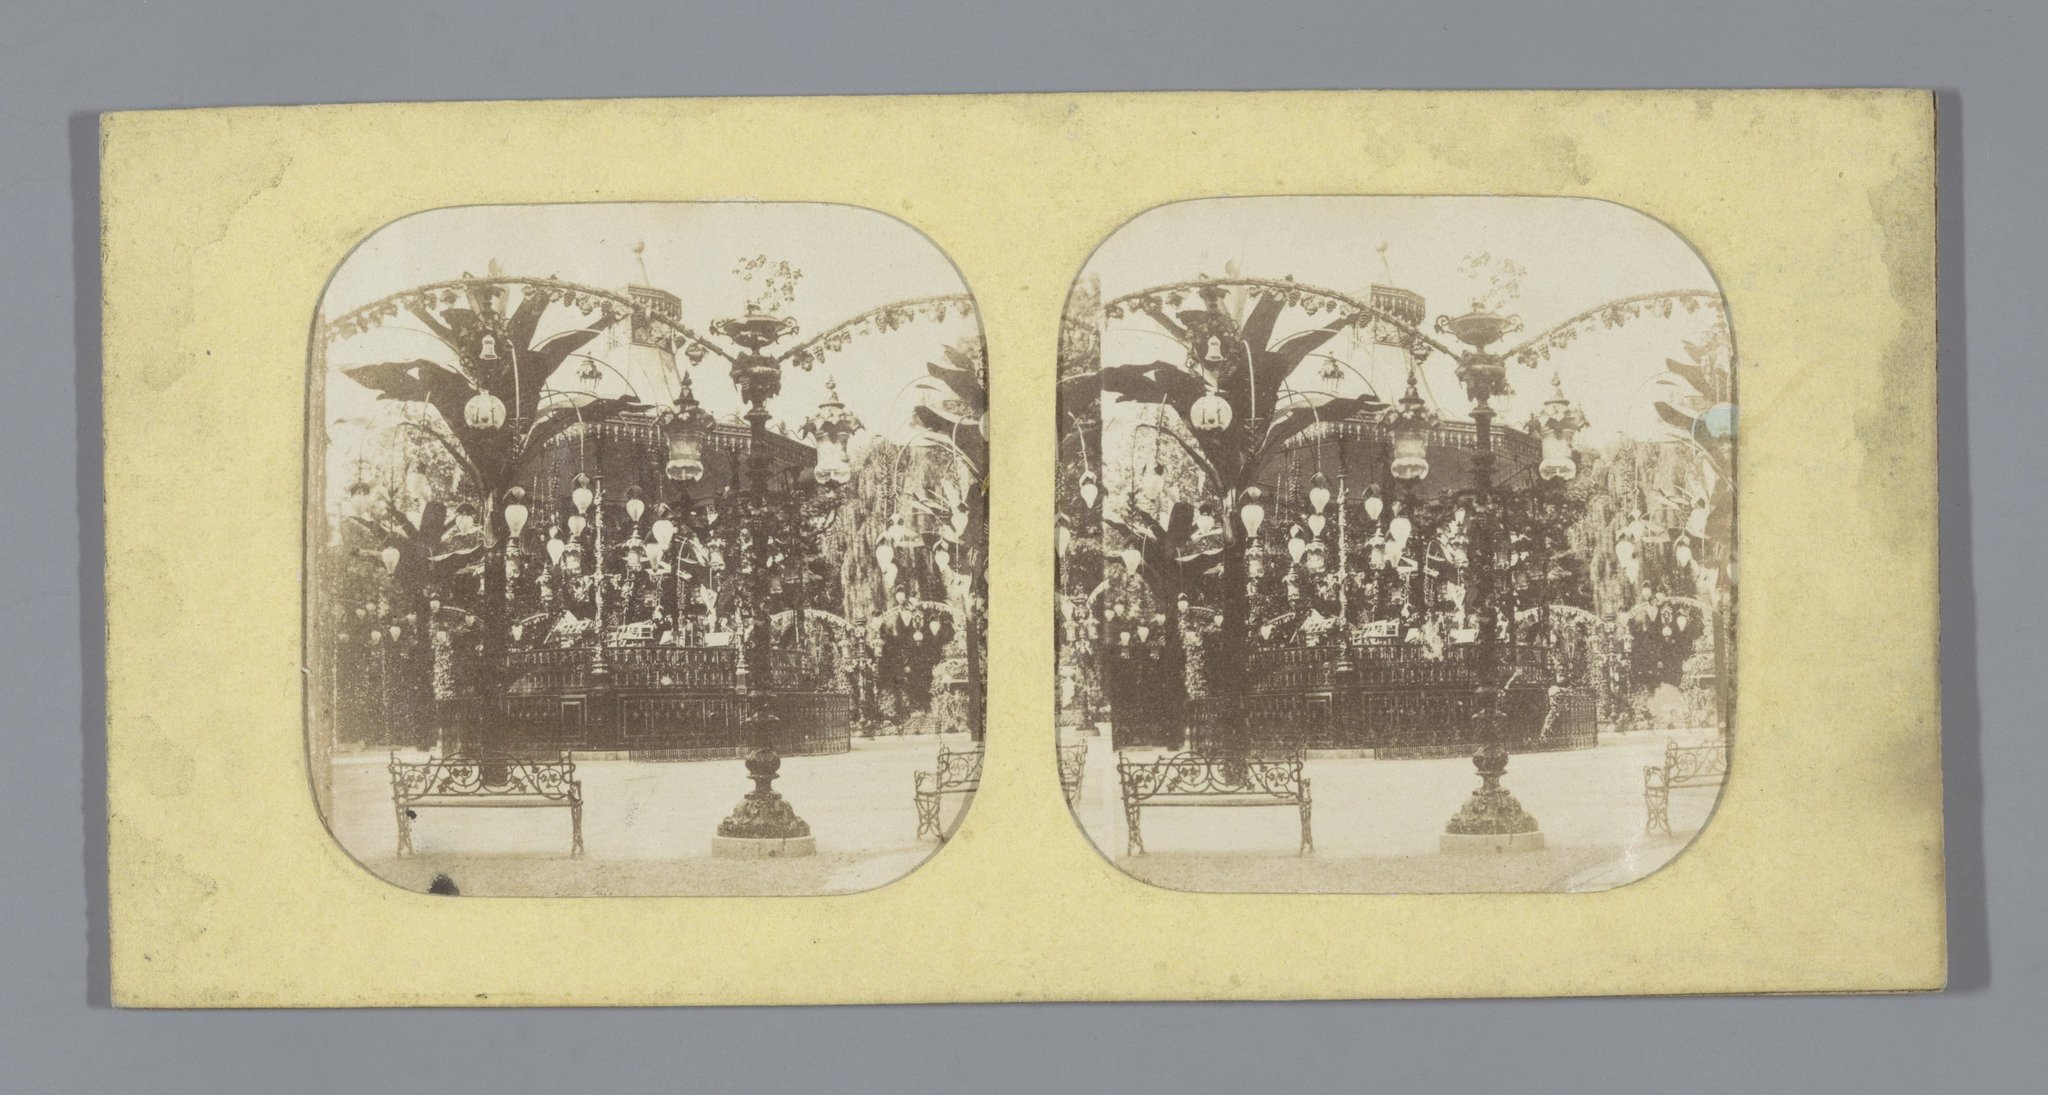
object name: tissue stereograph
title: Muziekkoepel in de Jardin Mabille, Parijs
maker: Anonymous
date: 1855-1875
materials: cardboard, paper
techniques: albumen print, hand coloring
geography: paris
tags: bandstand, farm or solitary house in landscape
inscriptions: inscription: ‘100-1/2 du [?]’